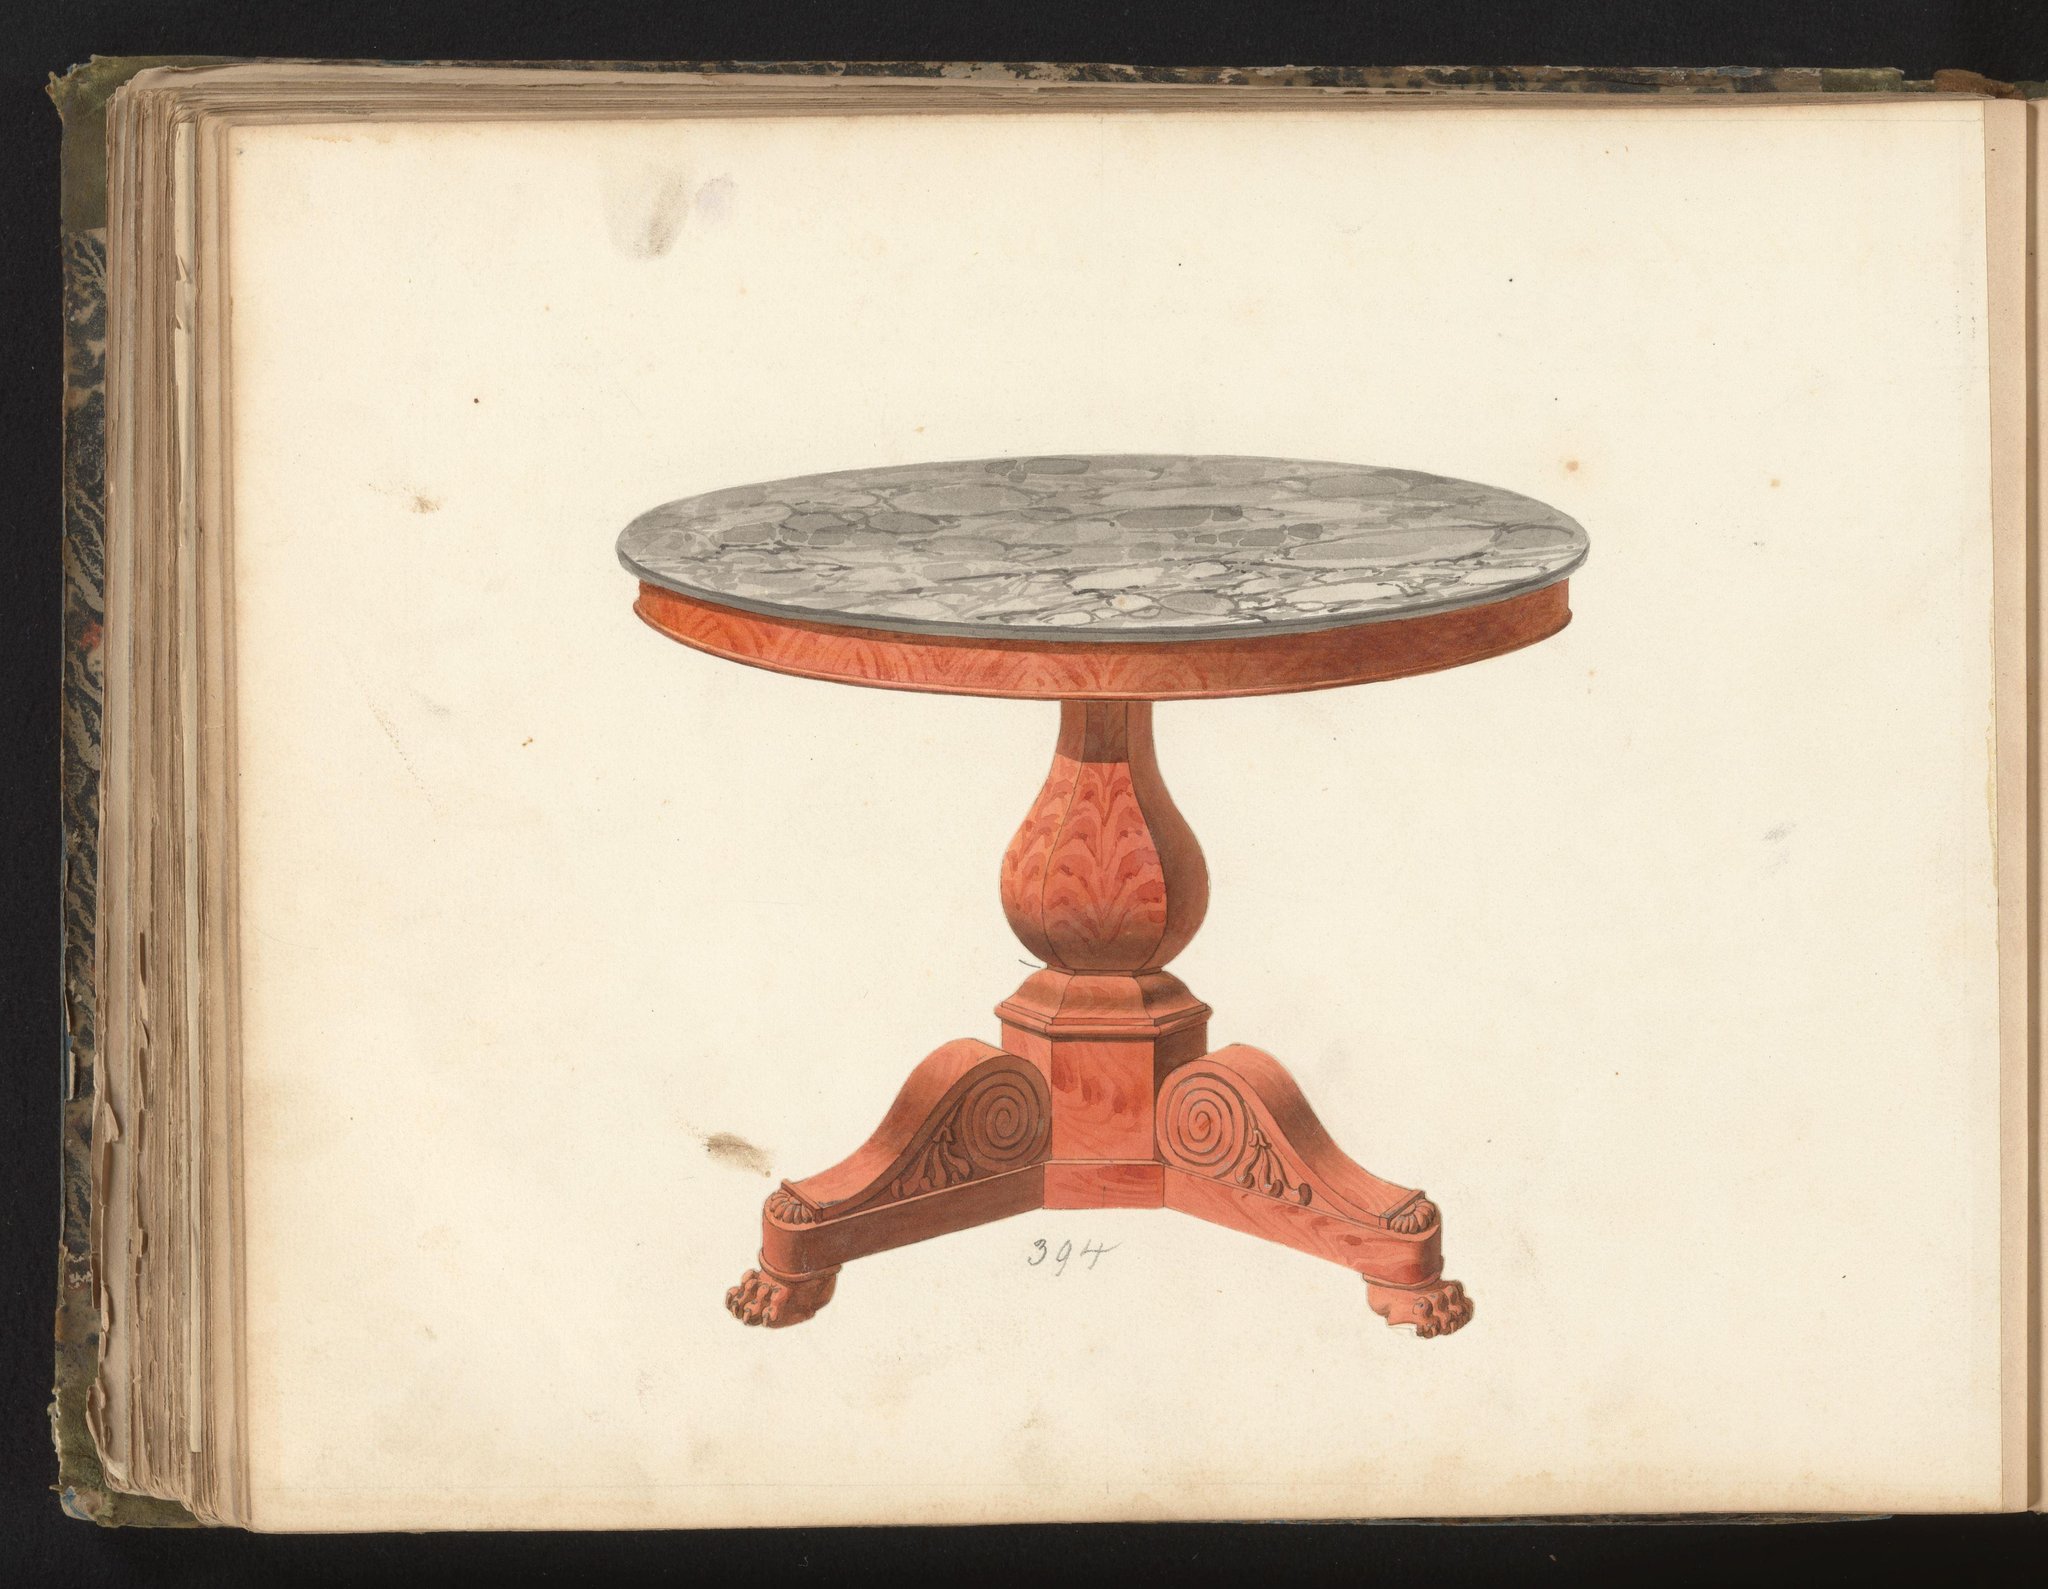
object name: drawing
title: Ontwerp voor een tafel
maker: Anonymous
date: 1825-1839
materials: ink, paper, pencil, watercolor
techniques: brush, pen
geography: paris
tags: table (+ wood and other phytogenic material), furniture to put things on (+ stone)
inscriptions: inscription: ‘394 Table à Modillon en acajou 30 33 36*’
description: Ontwerp voor een tafel met gebeeldhouwde mahoniehouten voet en rond, marmeren blad. Het blad op de achterzijde genummerd: 51, het tegenoverliggende blad met informatie over de afgebeelde meubelen genummerd: 51 bis. Onderdeel van een album met 80 bladen met tekeningen en een prent van gefineerde en gelakte meubelen, alsmede zitmeubelen.